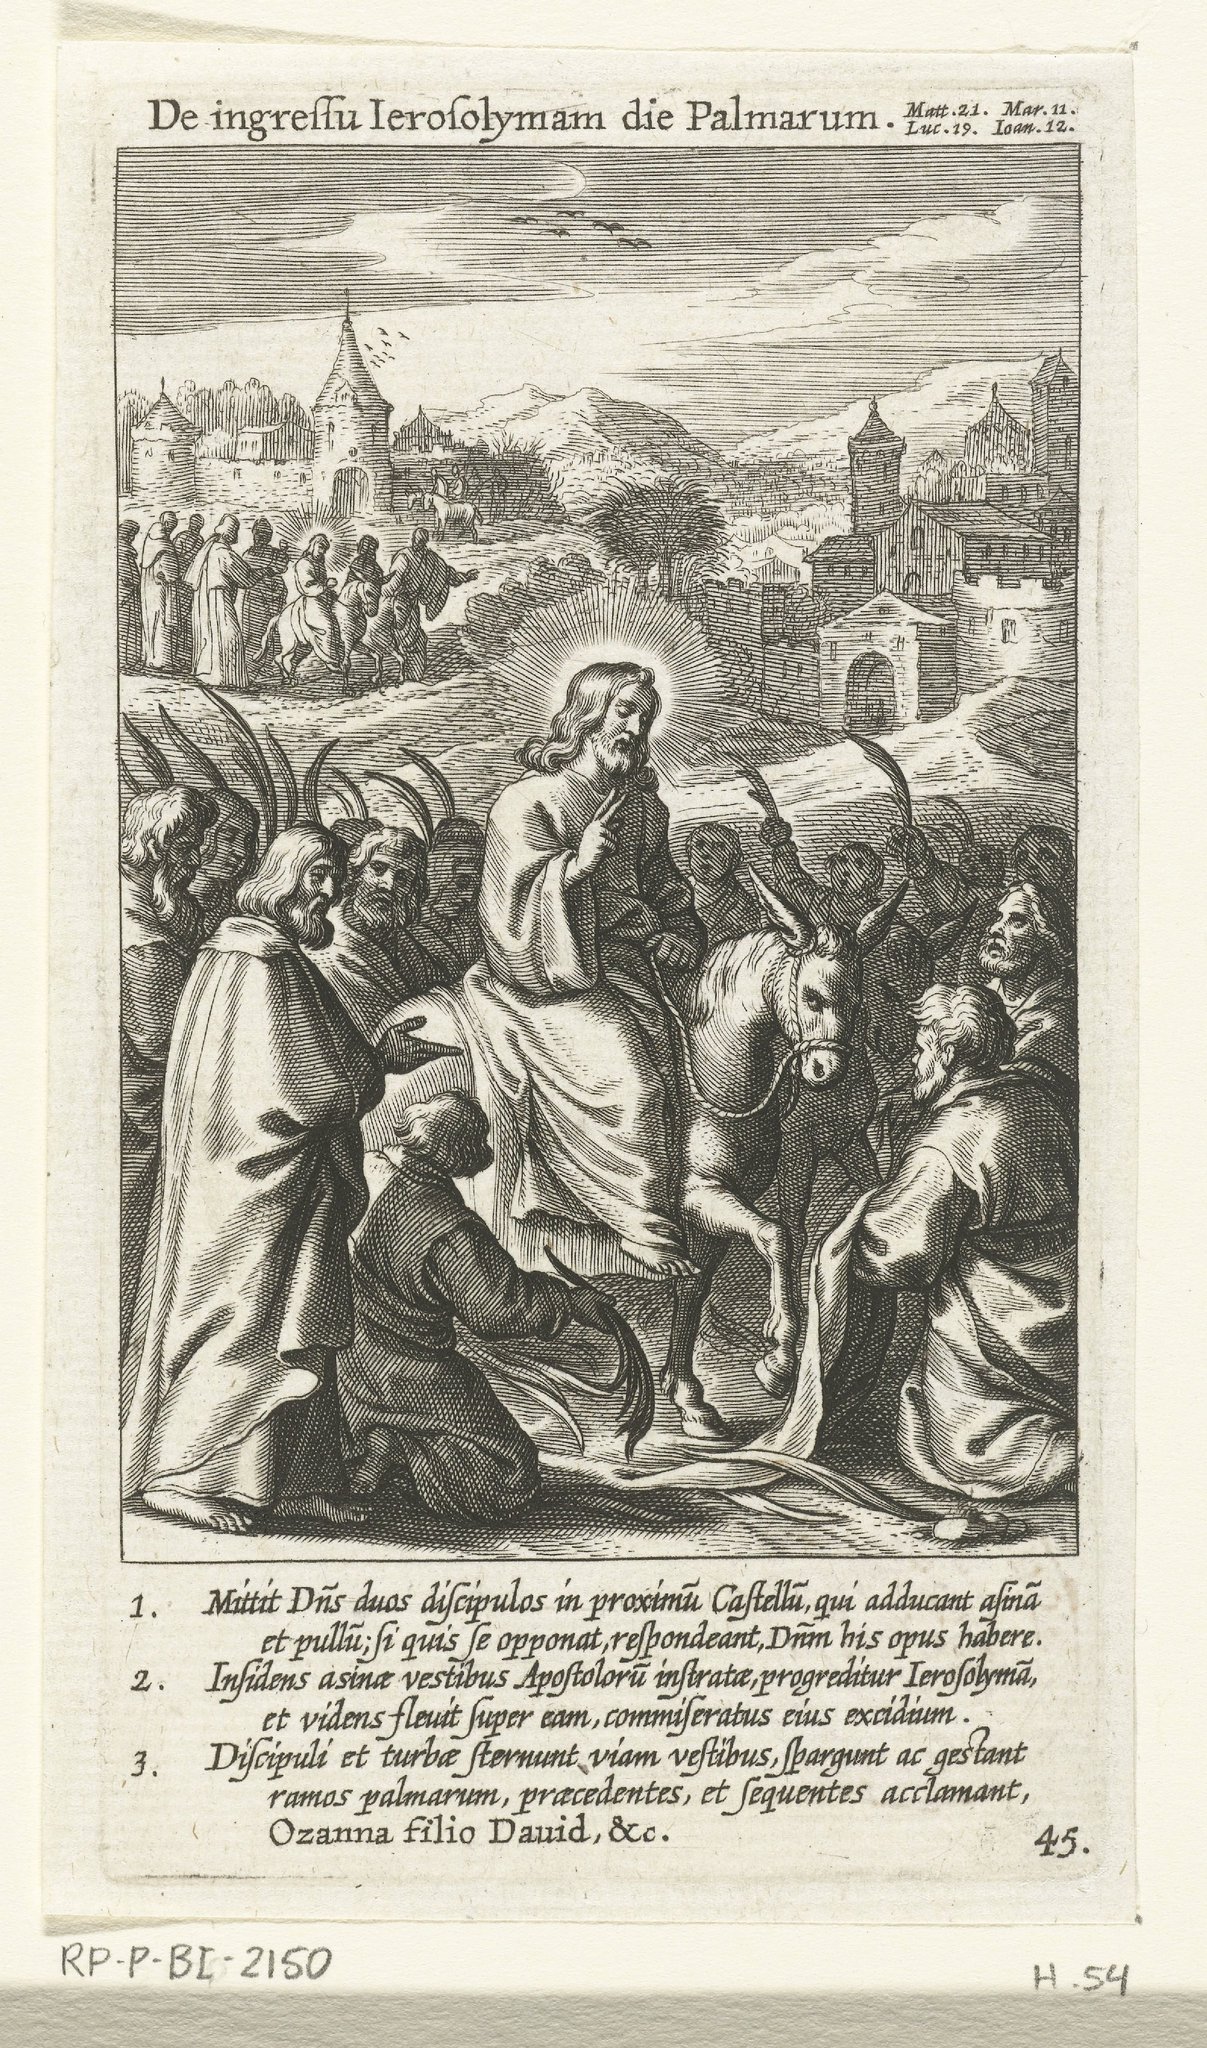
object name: book illustration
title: De ingressu Ierosolymam die Palmarum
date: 1590-1622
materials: paper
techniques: engraving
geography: antwerp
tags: entry into jerusalem: people spreading their clothes before christ on the ass, and waving palm branches (matthew 21:1-11, 21:14-16; mark 11:1-11; luke 19:28-40; john 12:12-19)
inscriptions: collector's mark: Lugt 240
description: Prent uit: Joannes Bourgois, Vitae passionis et mortis Jesu Christi Somini nostri mysteria, Antwerpen Hendrick Aertssens, 1622, afb. 45